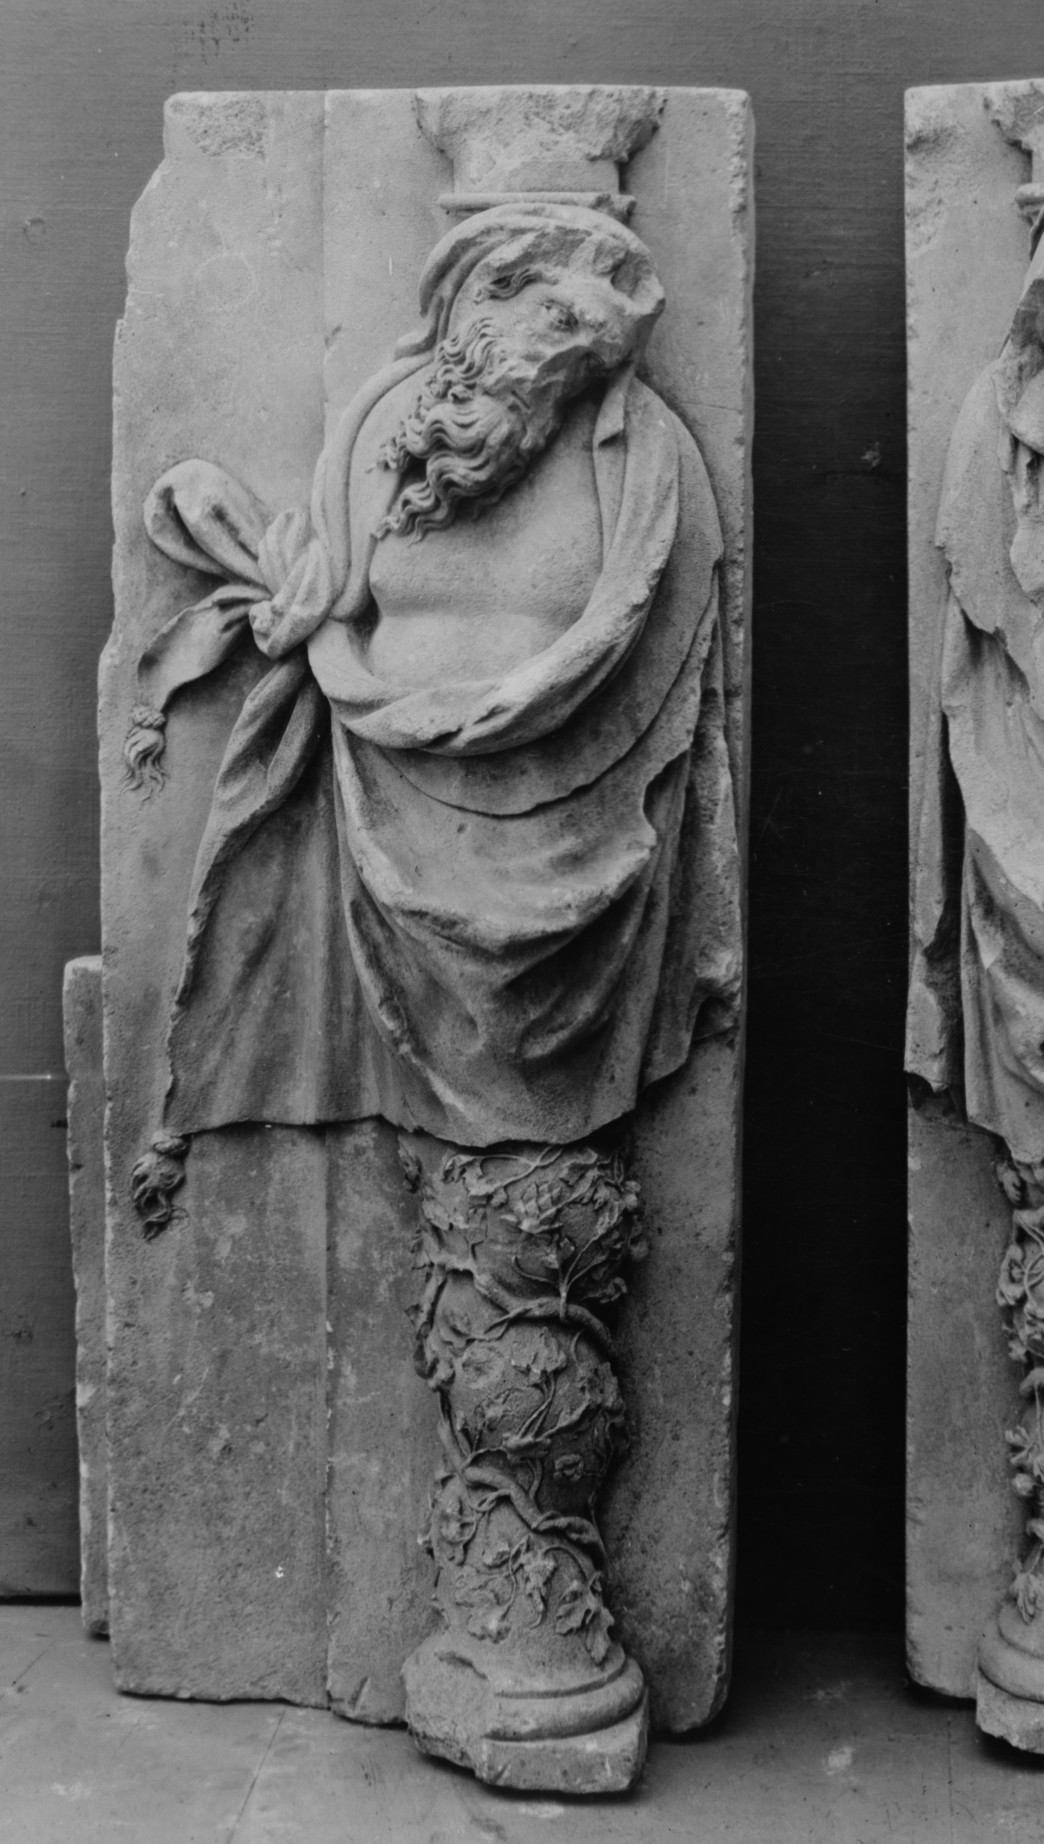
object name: caryatid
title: Caryatid (one of a pair)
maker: school of burgundy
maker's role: maker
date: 1551-1600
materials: stone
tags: caryatids